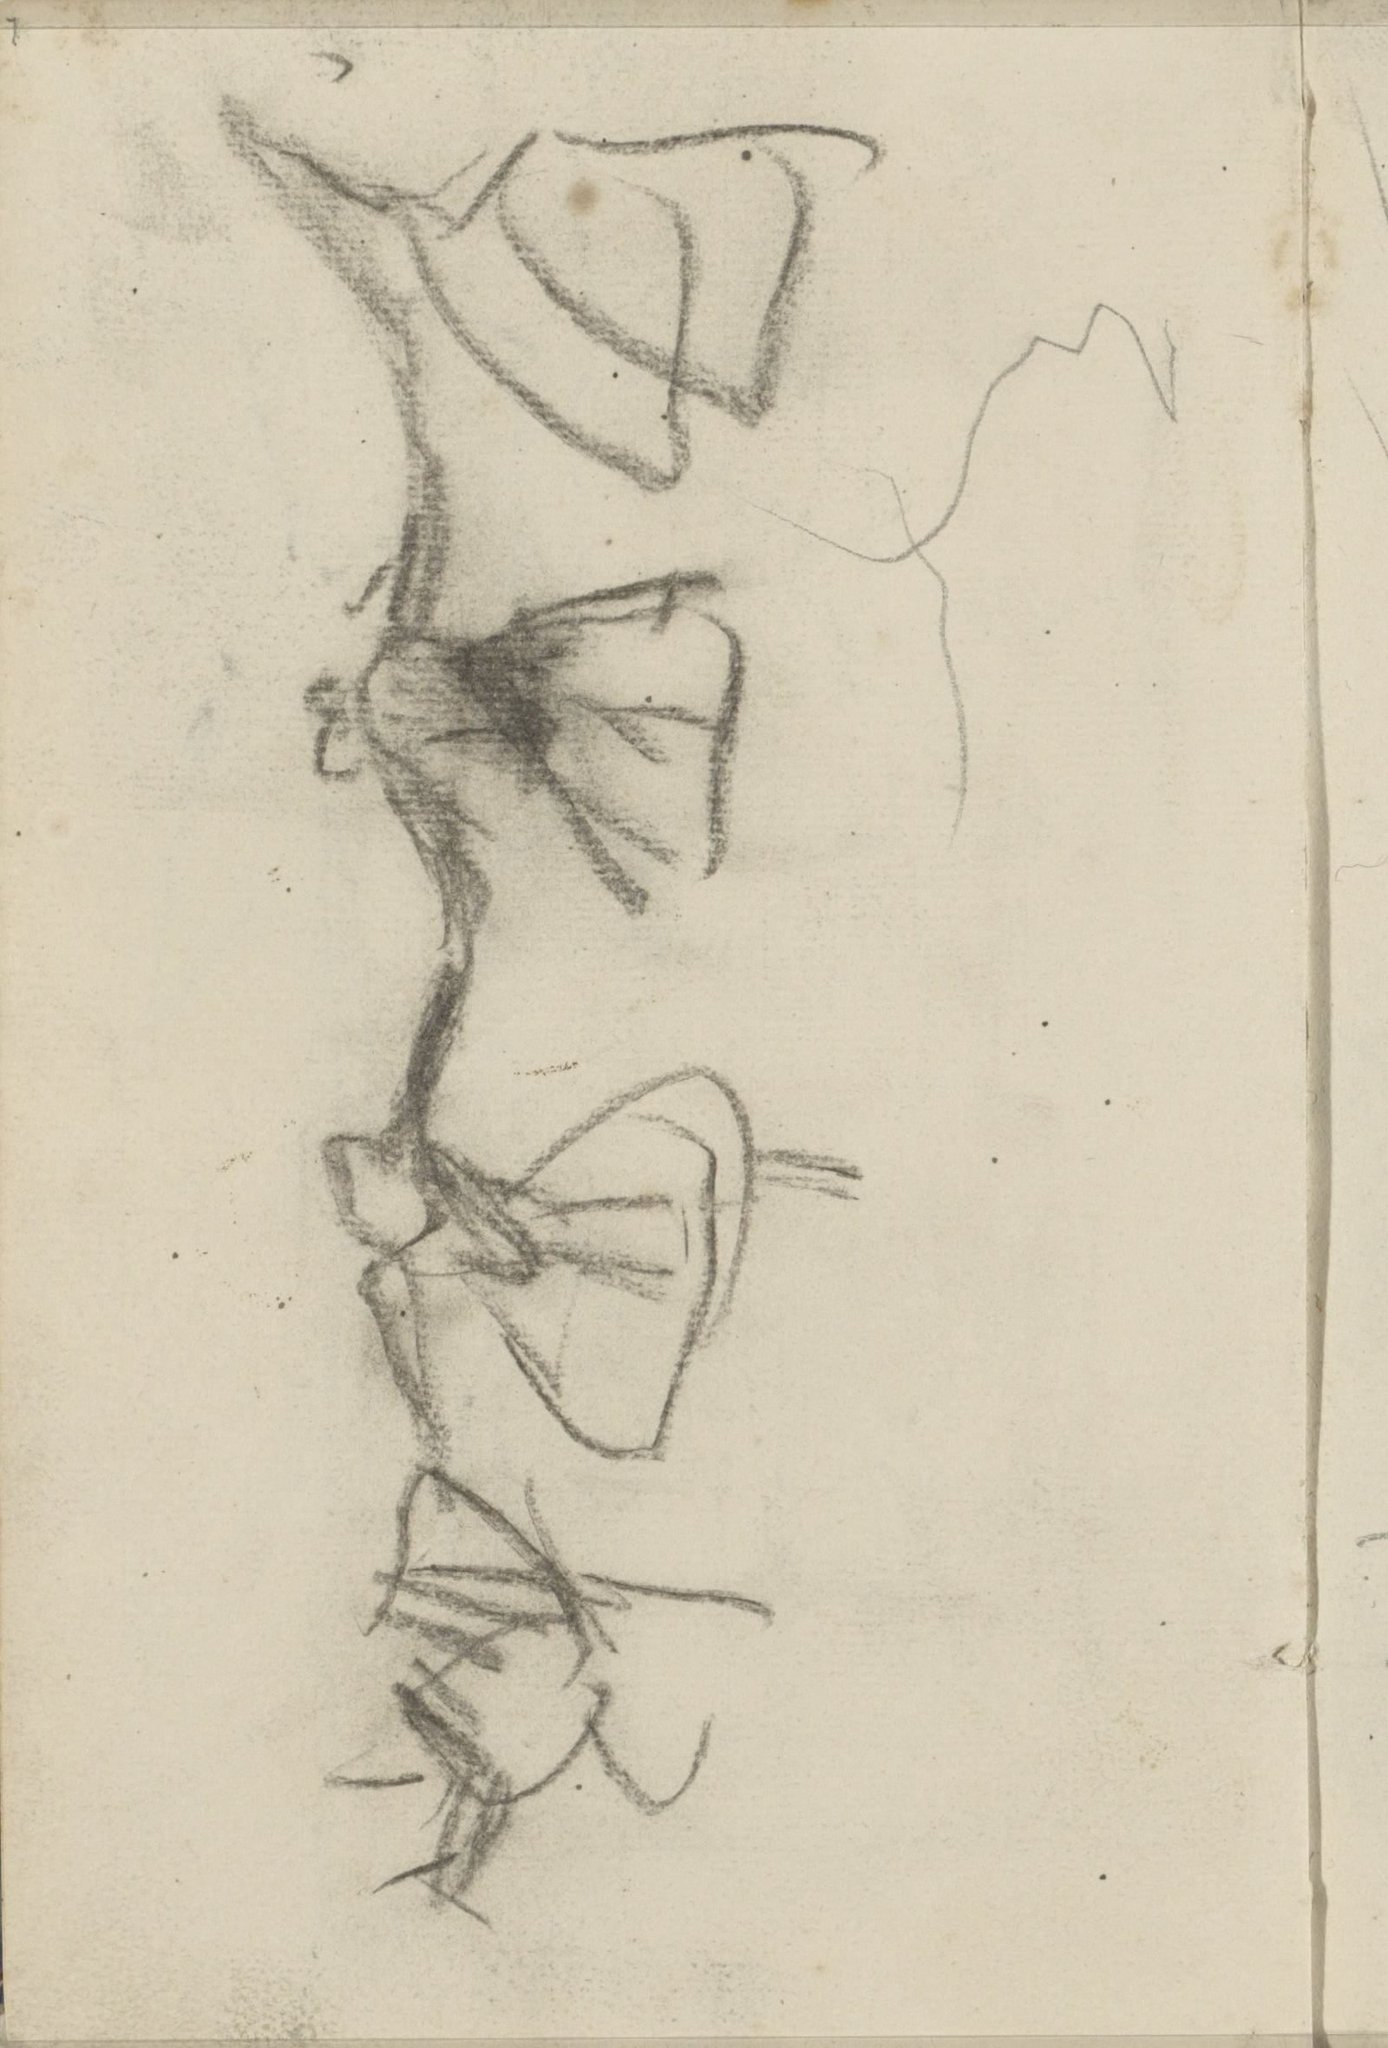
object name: sketchbook leaf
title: Vier meisjes die elkaars hand vasthouden, mogelijk dansend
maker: george hendrik breitner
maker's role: draughtsman, painter, print maker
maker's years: 1857-1923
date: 1886-1898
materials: chalk, paper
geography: amsterdam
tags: girl (child between toddler and youth) (+ four persons), gripping someone by the hand or the wrist; clasped hands - aa - both arms or hands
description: Pagina 7 uit een schetsboek met 18 bladen.